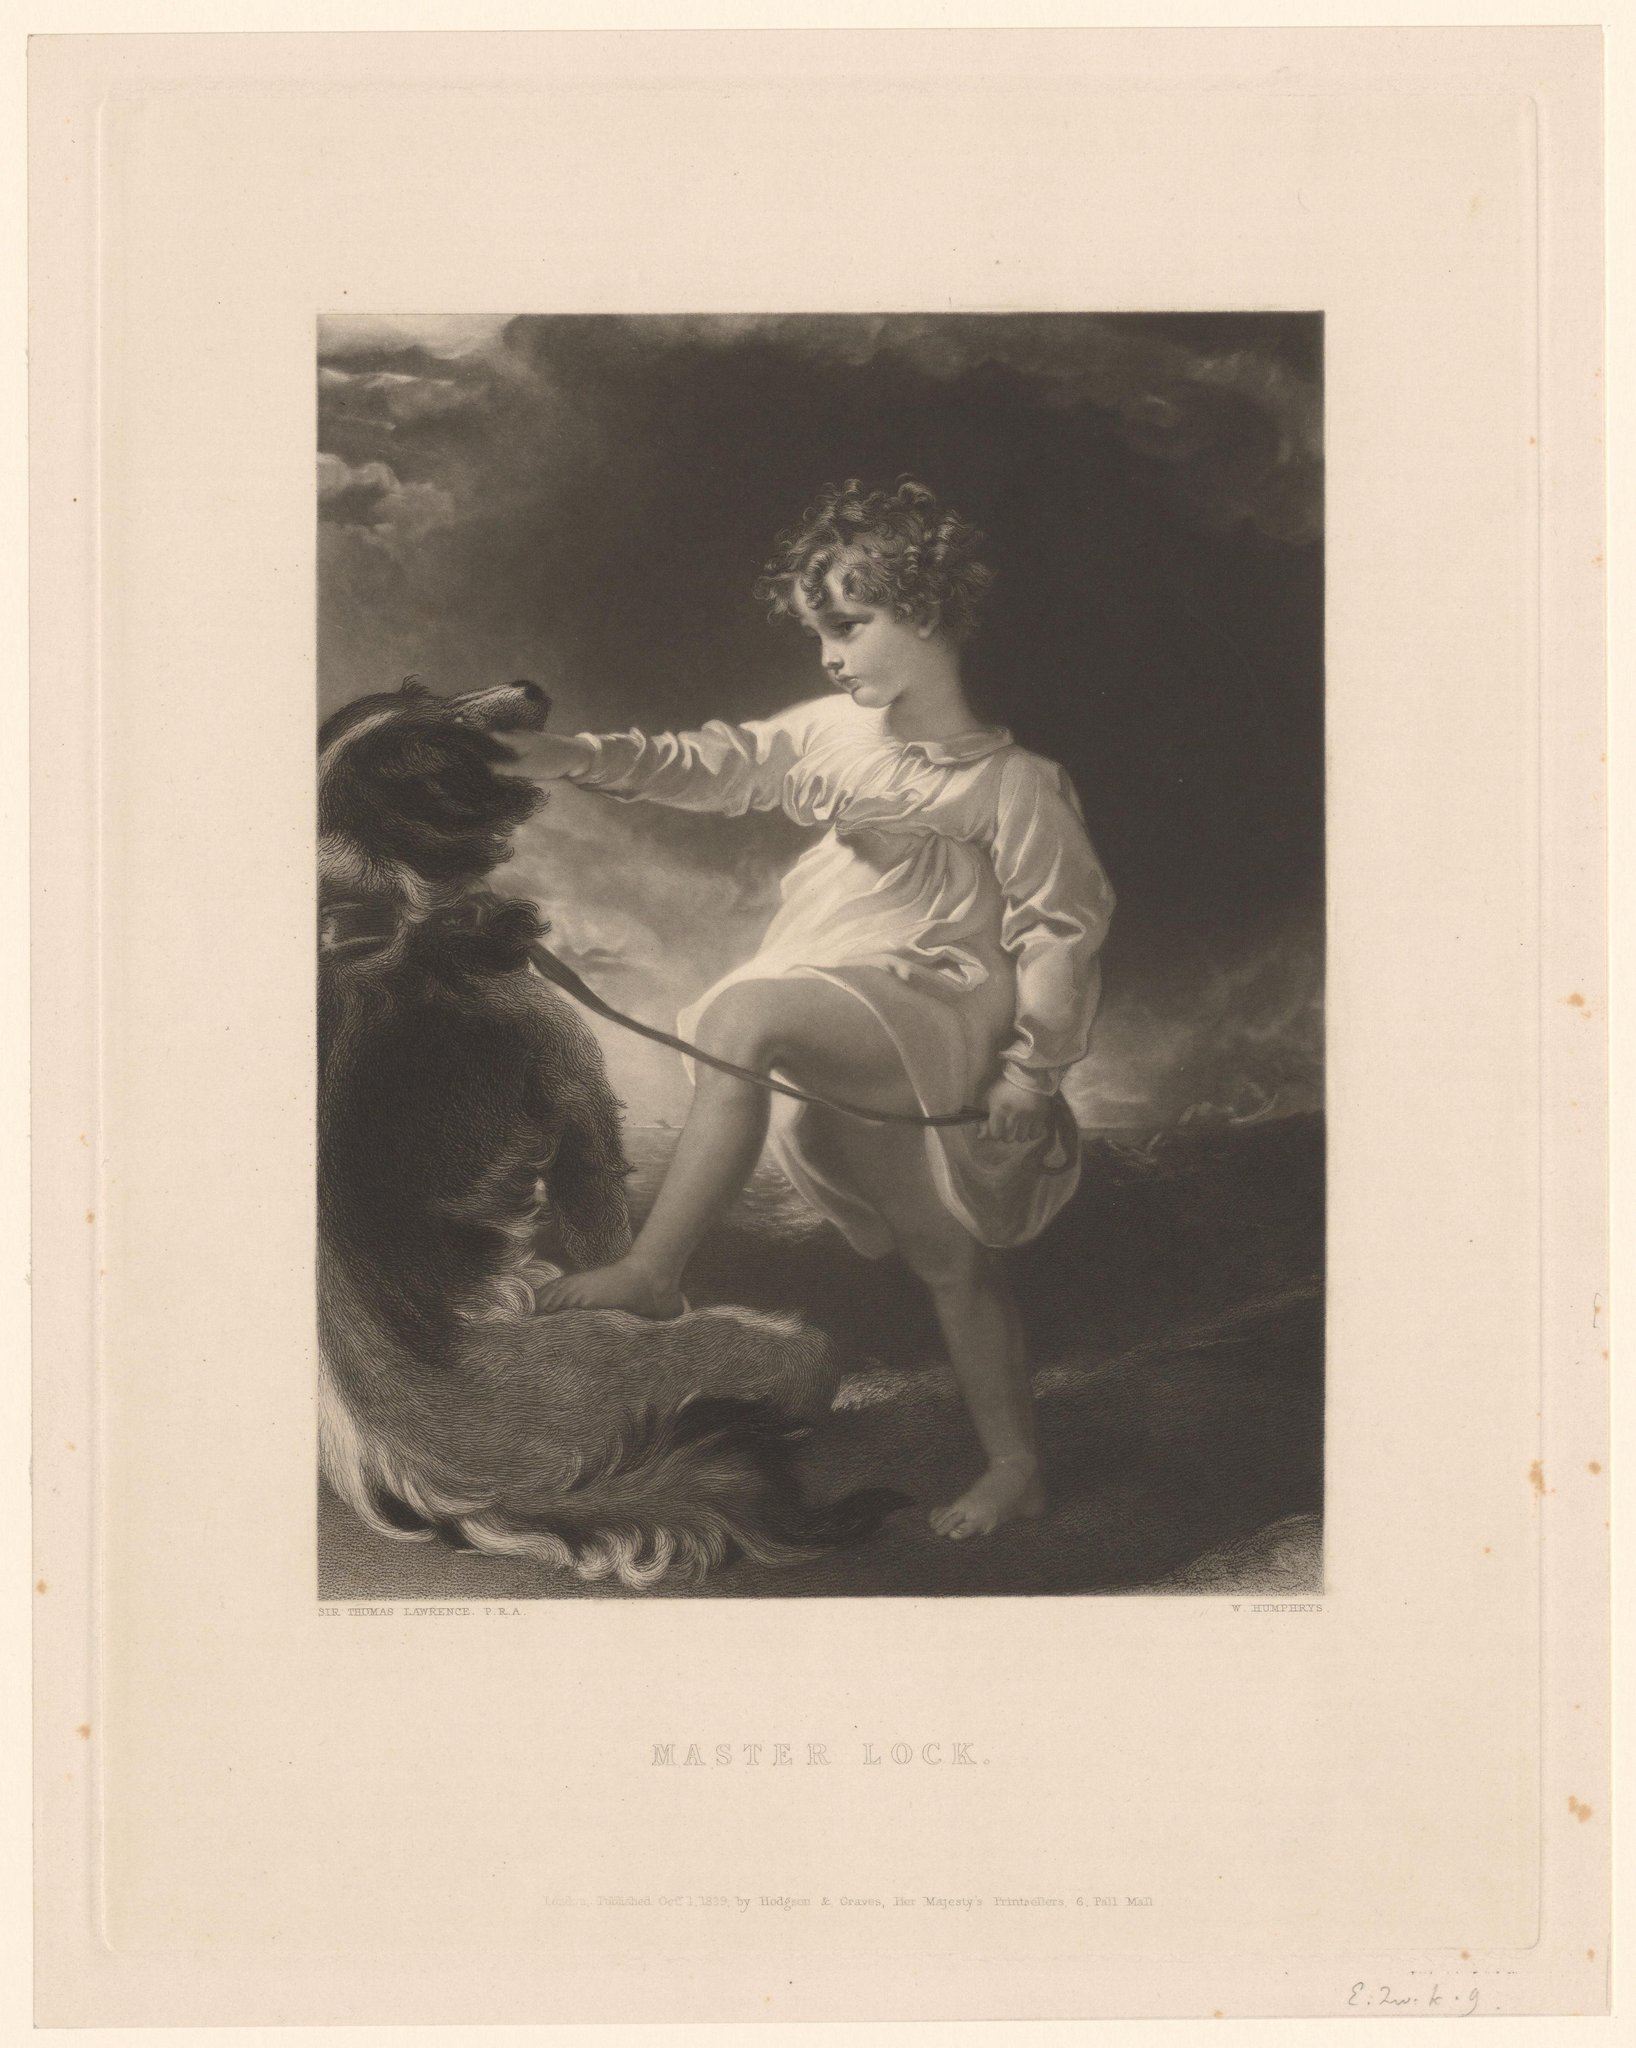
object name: print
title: Hond vastgehouden door jongen, mogelijk William Lock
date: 1839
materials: paper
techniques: etching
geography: london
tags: painter, historical persons, dog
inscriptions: collector's mark: Lugt 2228